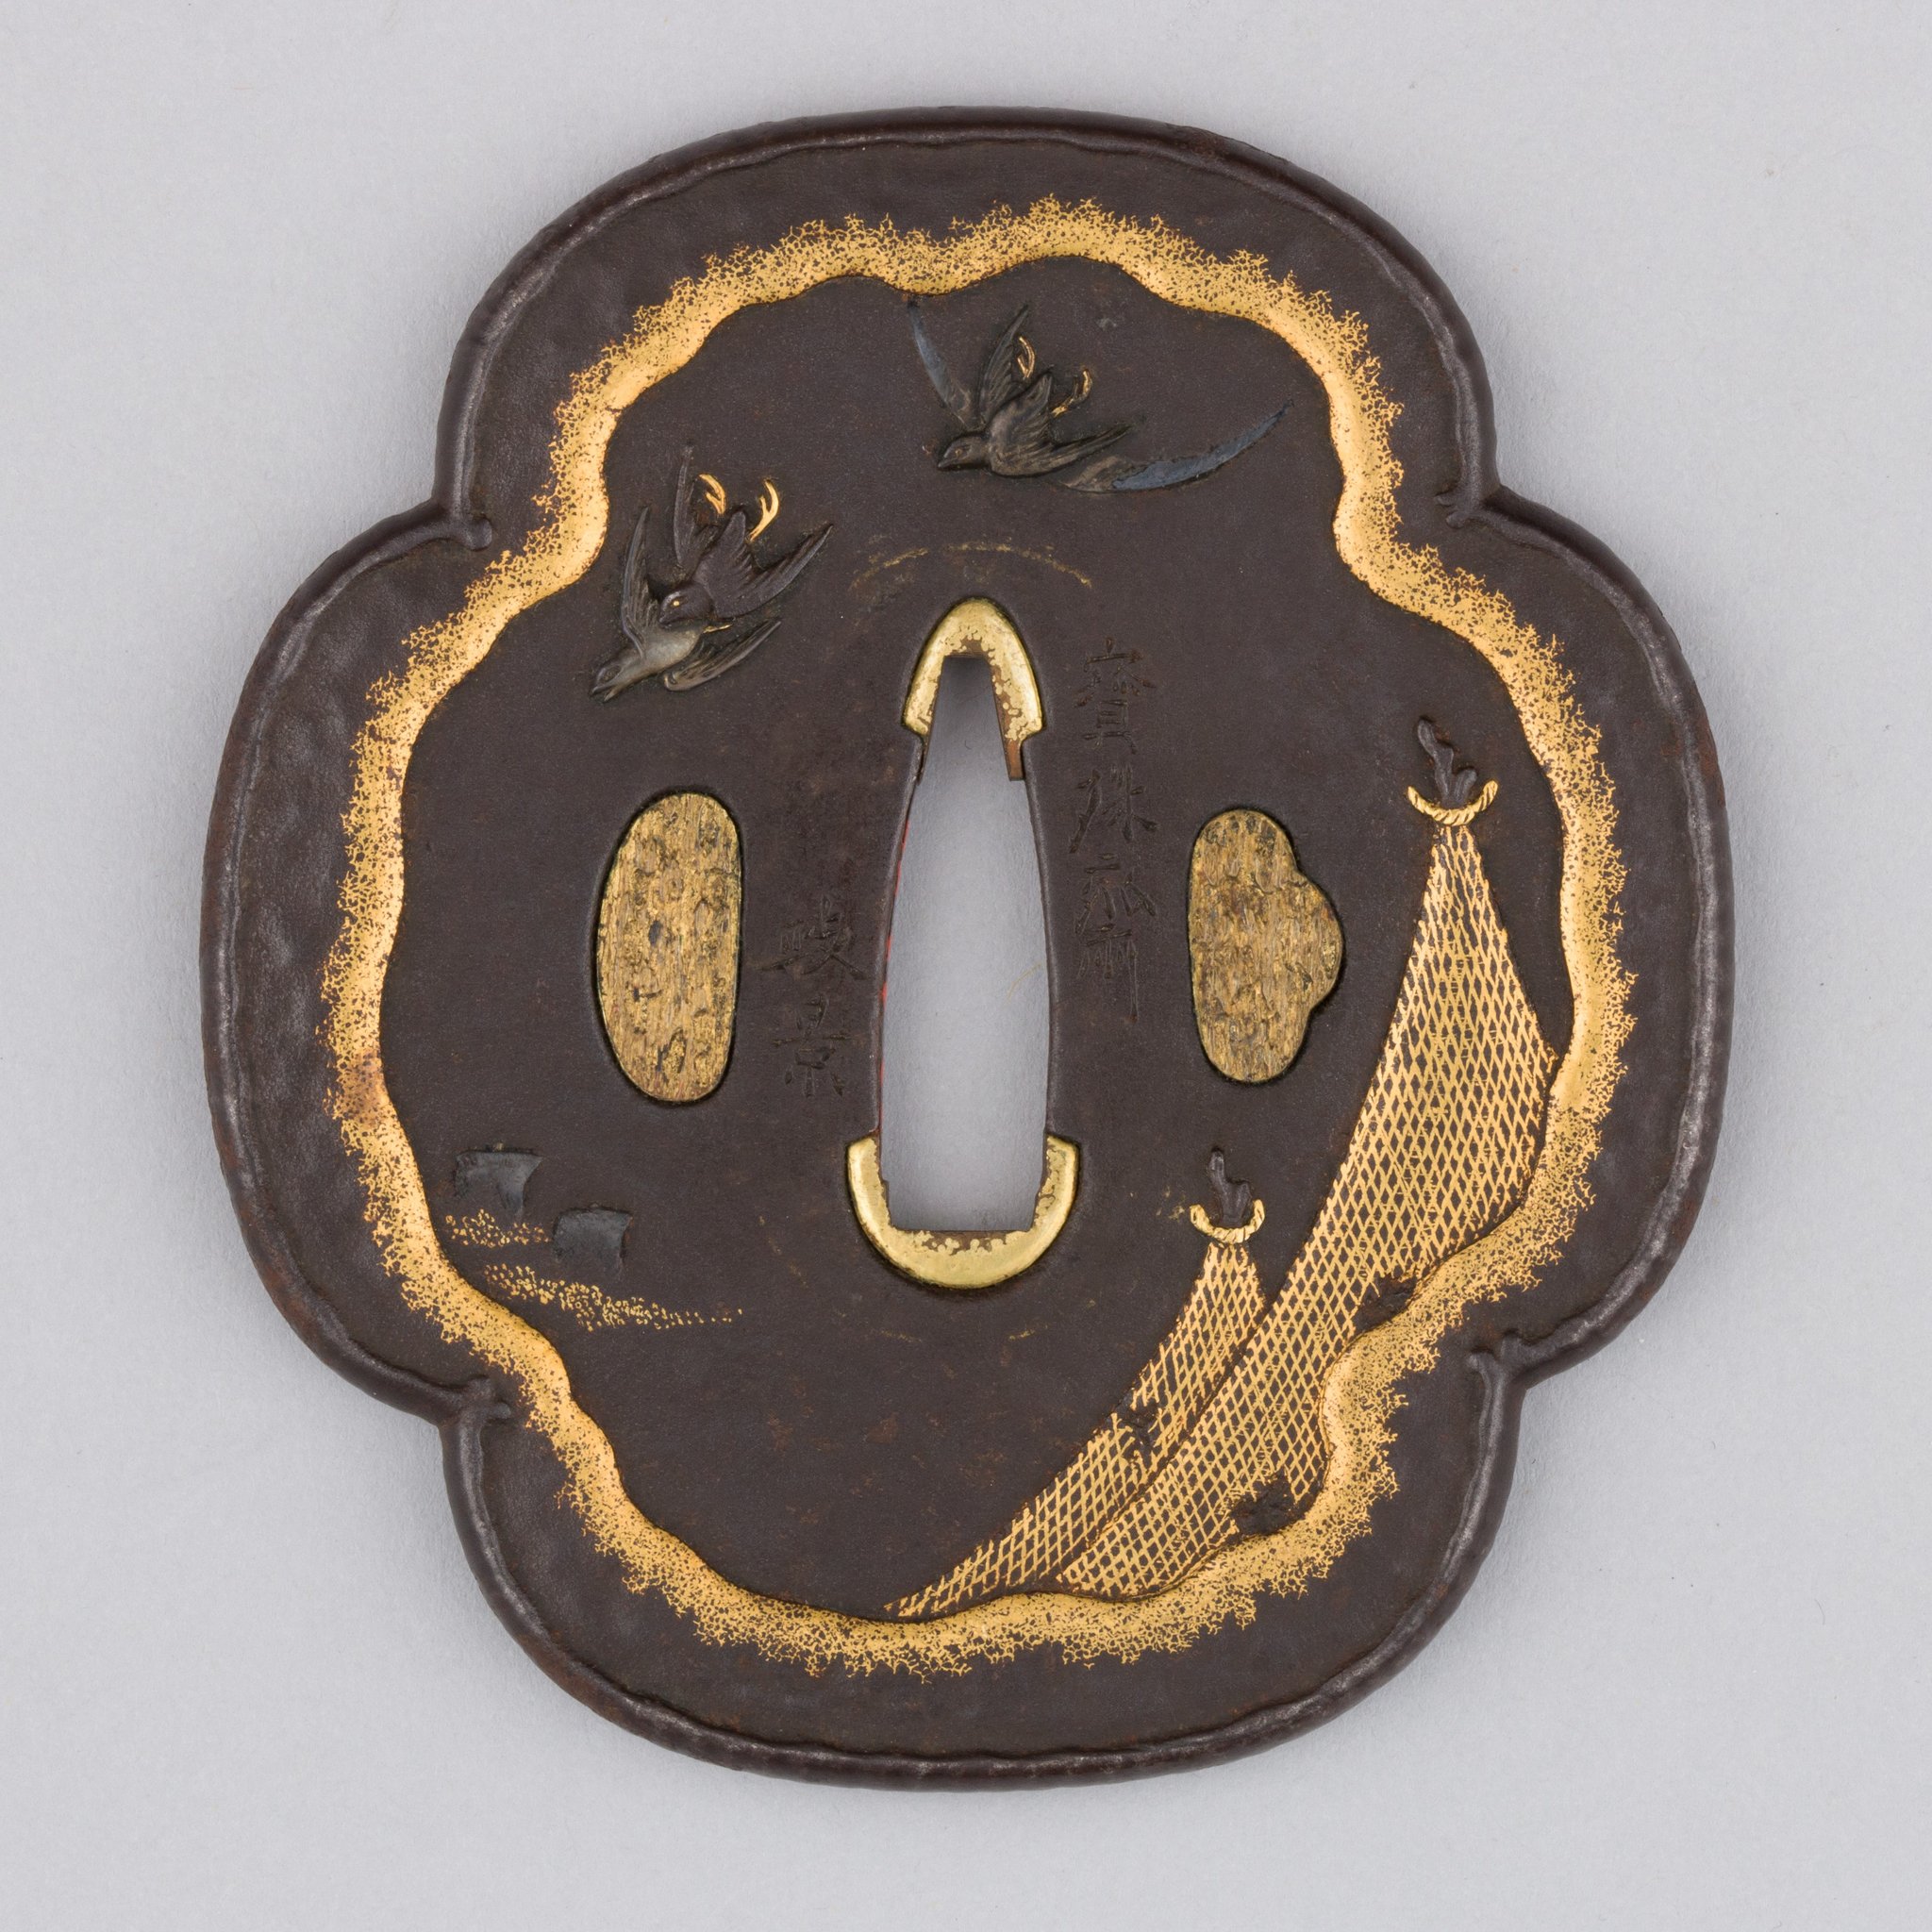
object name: sword guard tsuba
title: Sword Guard (Tsuba)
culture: japanese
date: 1801-1900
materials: copper, gold, iron, silver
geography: japan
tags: birds